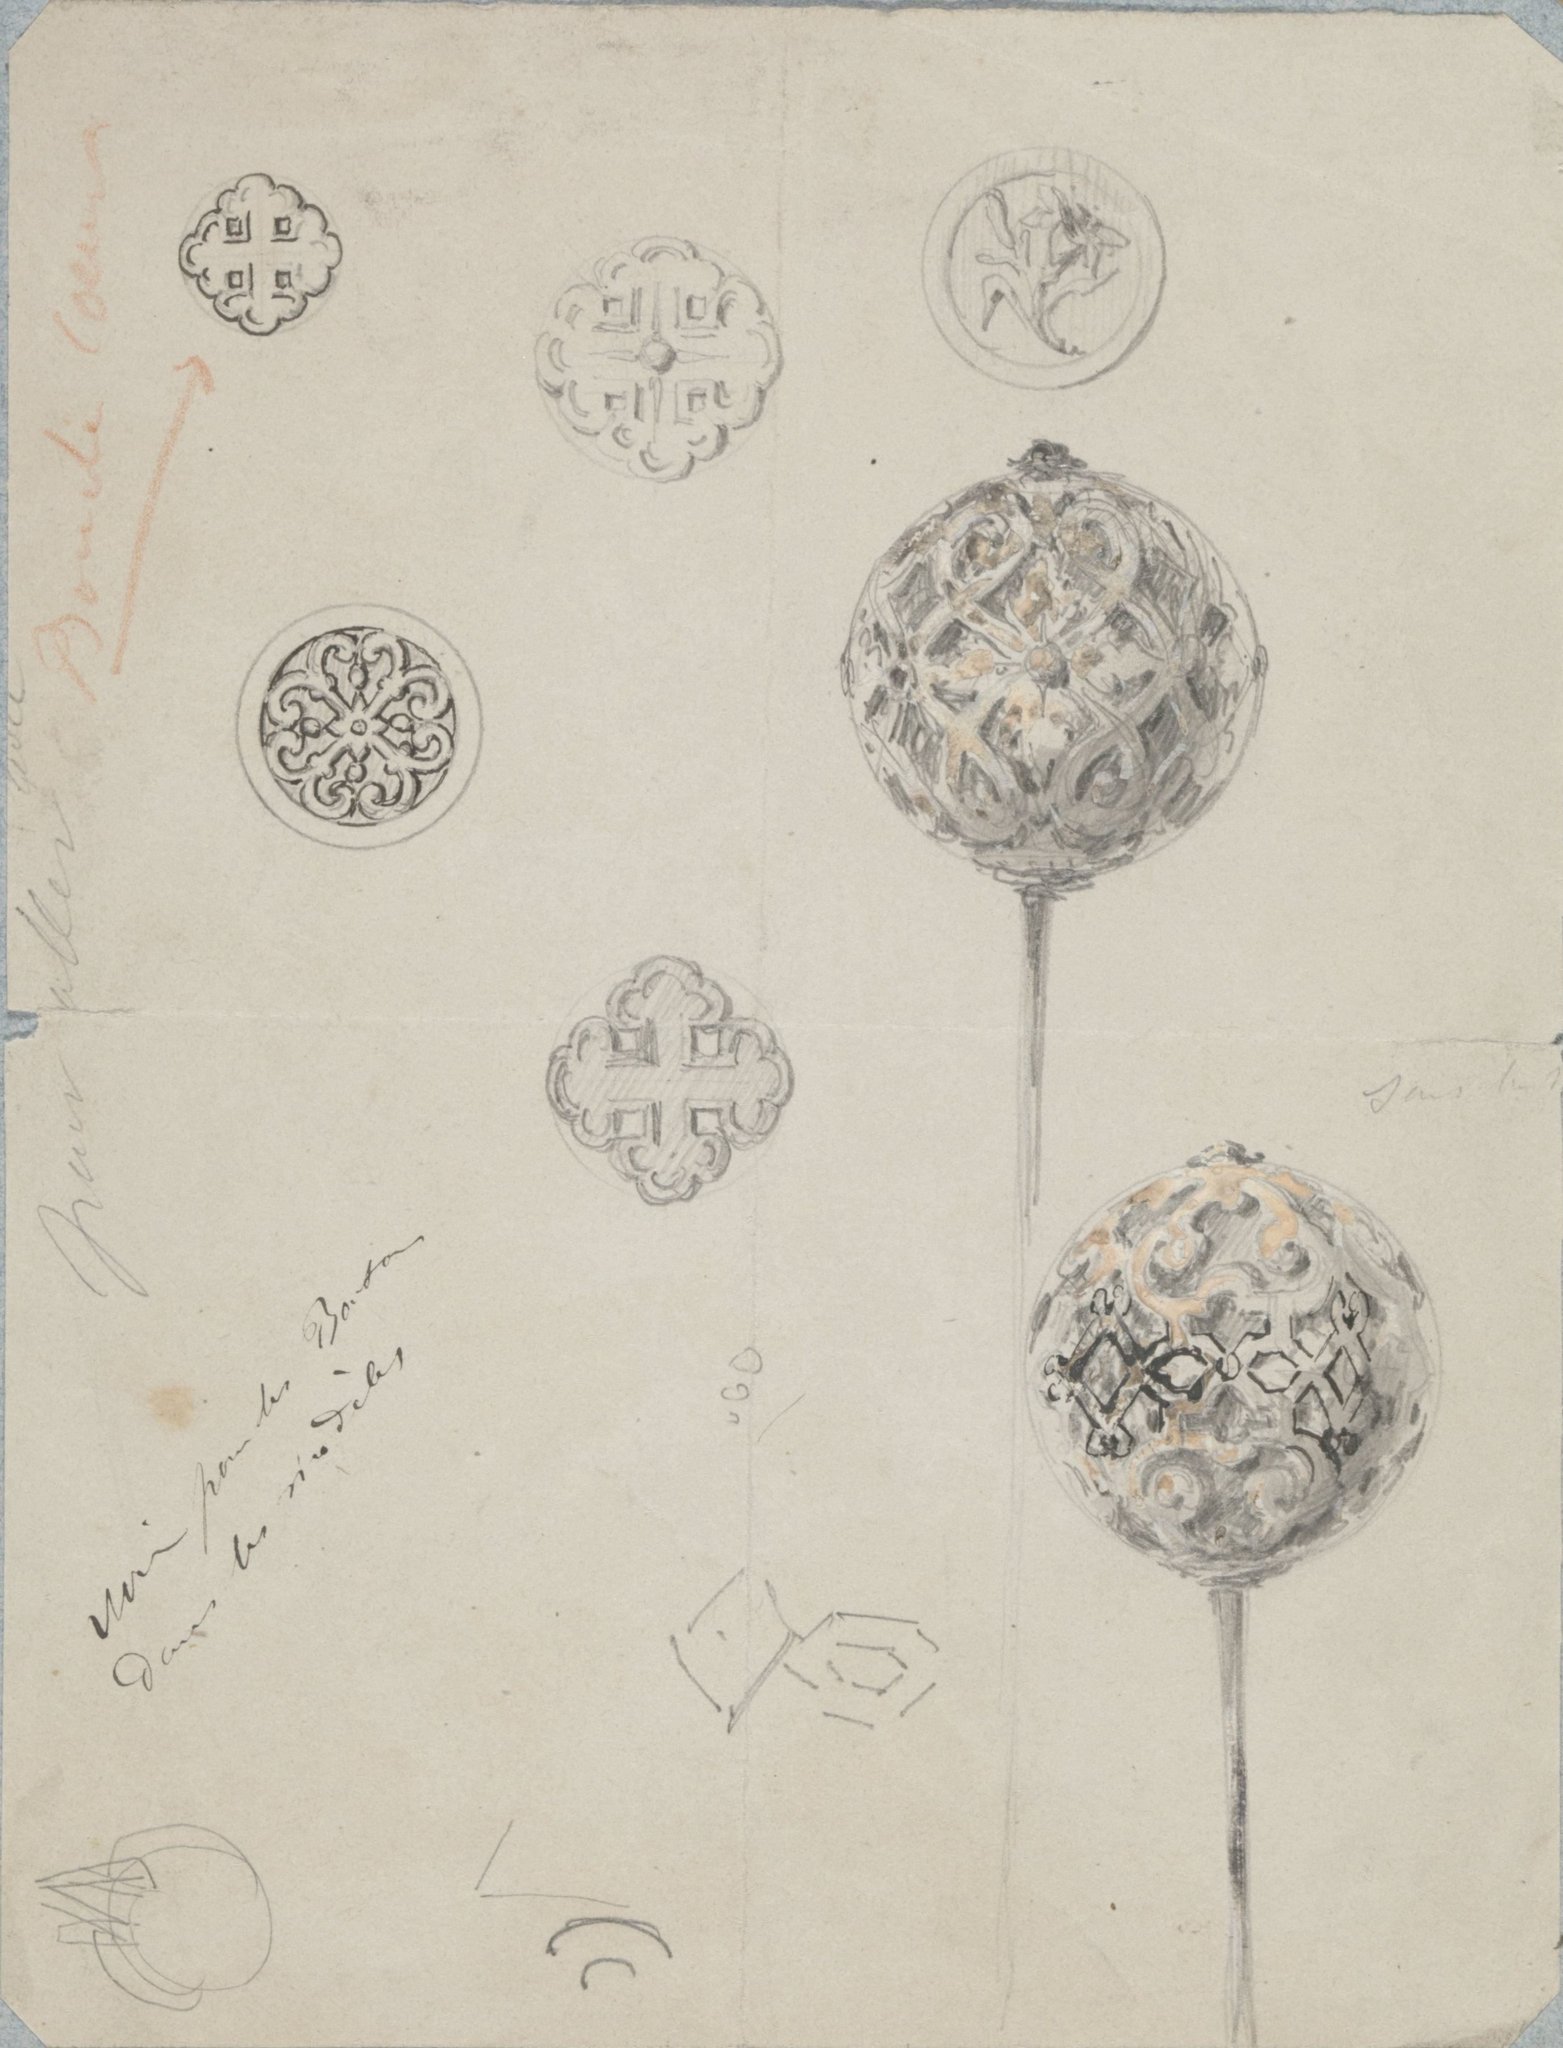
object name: design drawing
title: Ontwerpen voor steeknaalden met opengewerkte bollen, medaillons en Malteser kruizen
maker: henri cameré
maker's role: designer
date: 1864-1894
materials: paint, ink, paper, pencil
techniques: brush, pen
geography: paris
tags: ornaments, jewels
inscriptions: inscription: ‘Boucle coeur’, inscription: ‘Voir pour des Boutons dans les modèles’, inscription: ‘pour aller / sous […]’